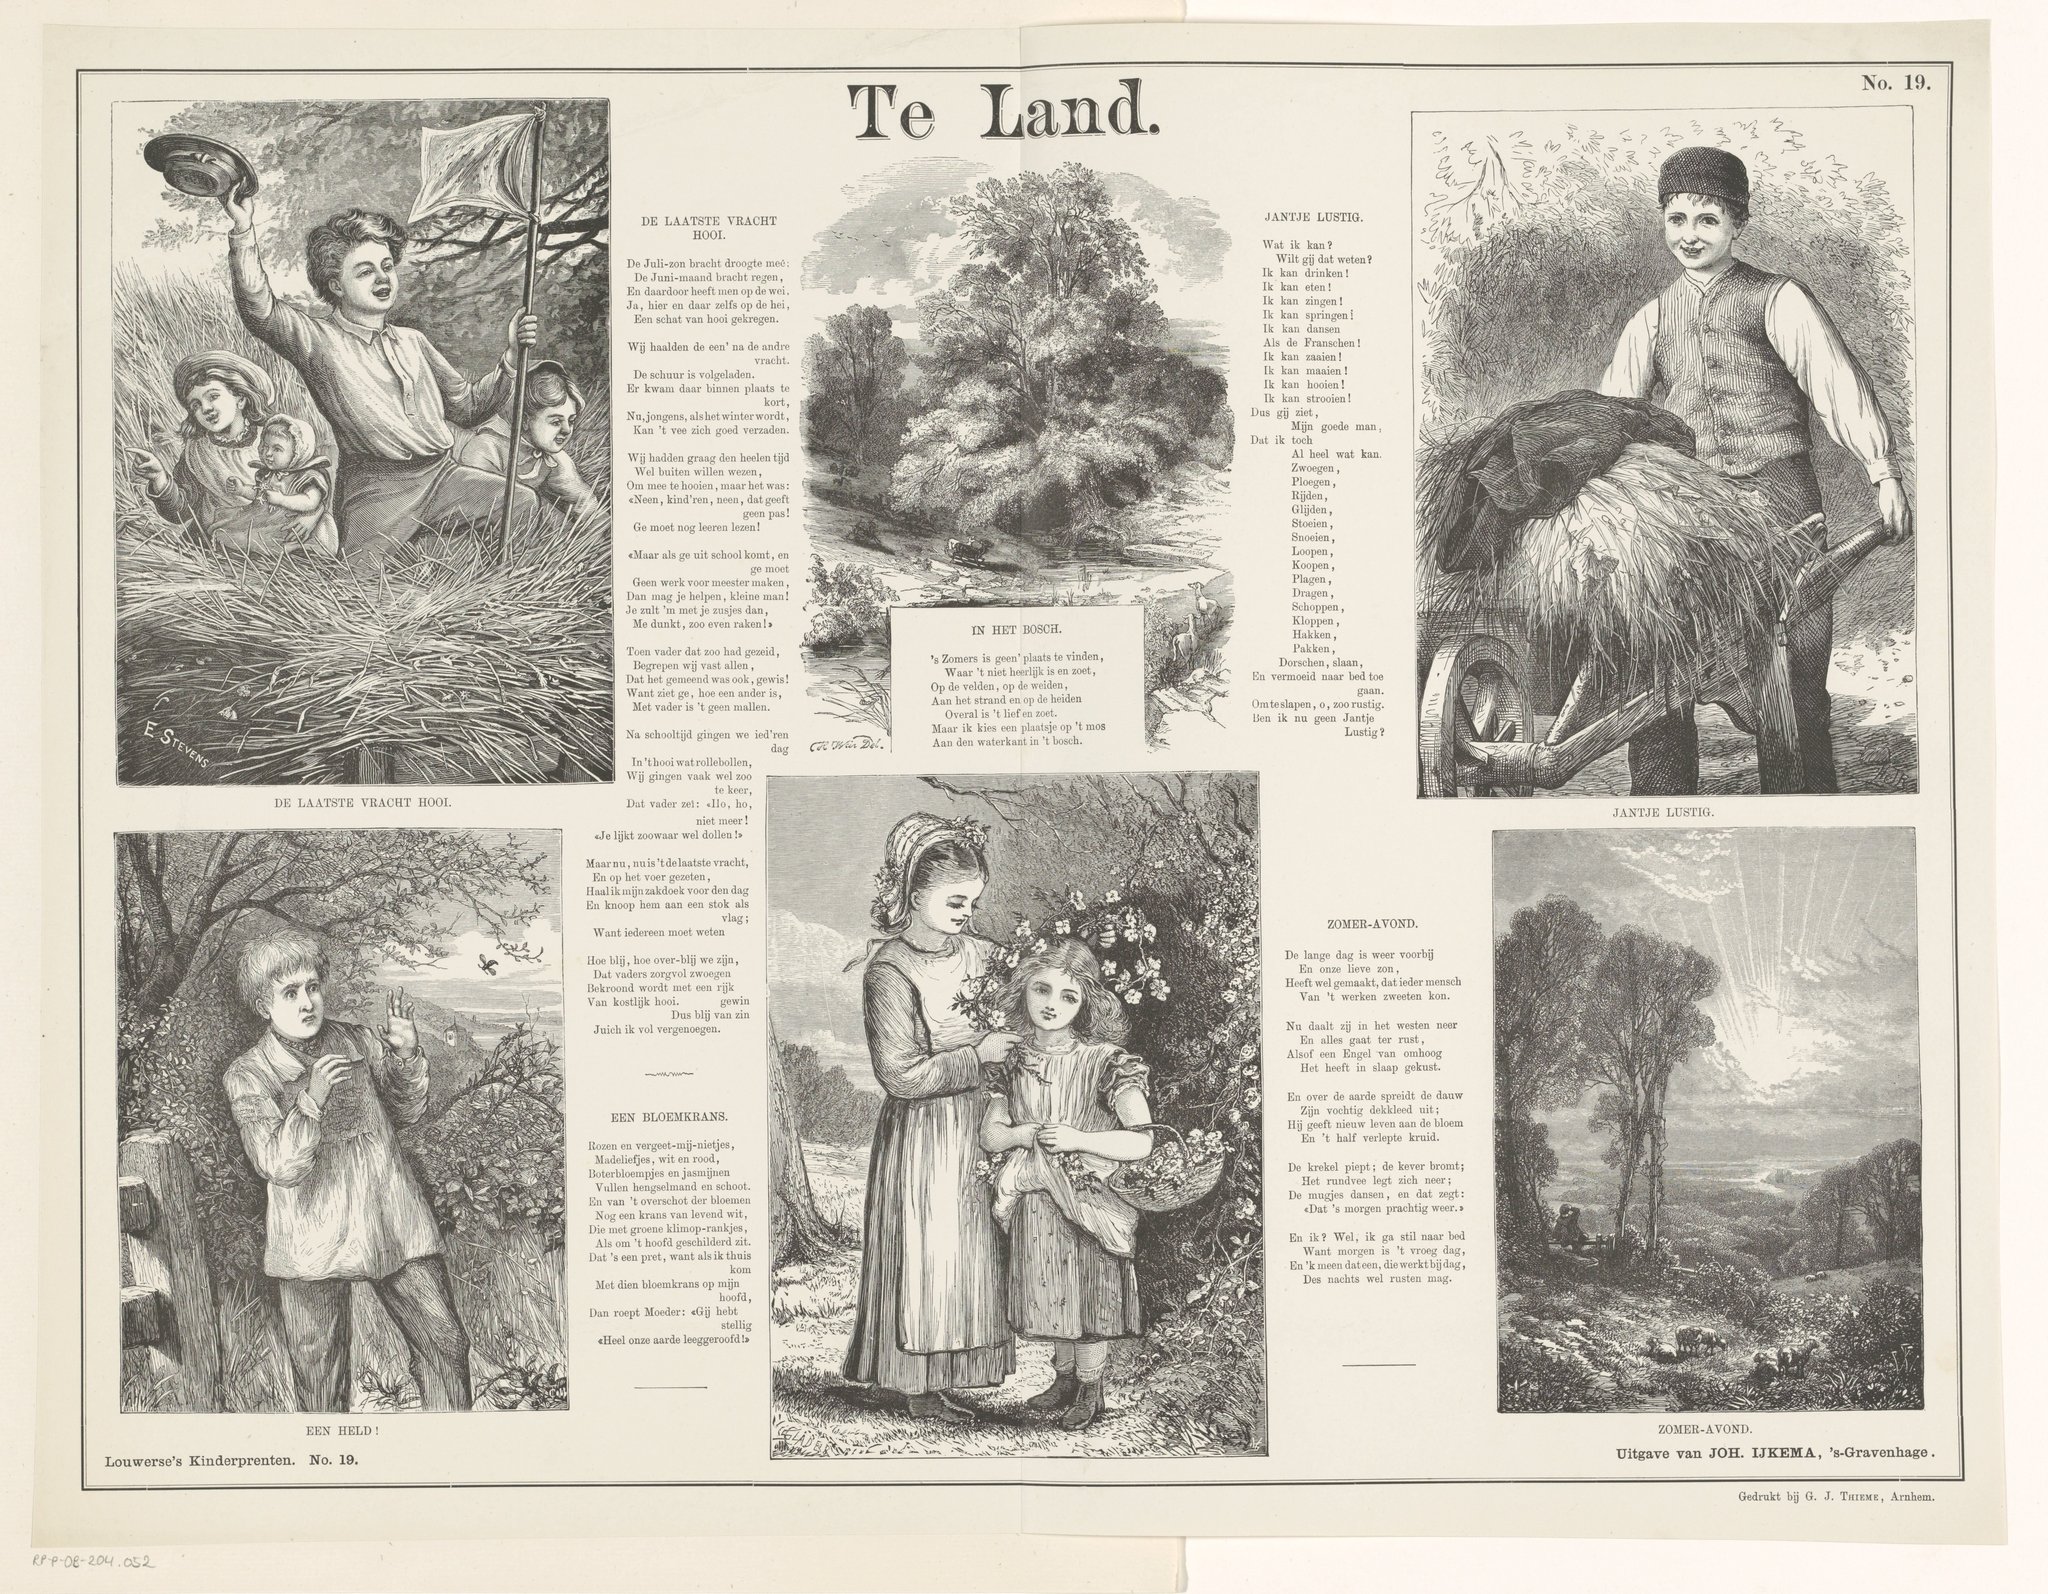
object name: popular print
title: Te land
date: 1882-1905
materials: paper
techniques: letterpress printing, printing block, engraving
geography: the hague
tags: enjoying nature, children's games and plays, landscapes, child and nature (games and plays)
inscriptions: collector's mark: Lugt 2760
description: Blad met 6 voorstellingen van kinderen op het platteland en landschappen. Tussen de afbeeldingen versjes in boekdruk. Genummerd rechtsboven en linksonder: No. 19.